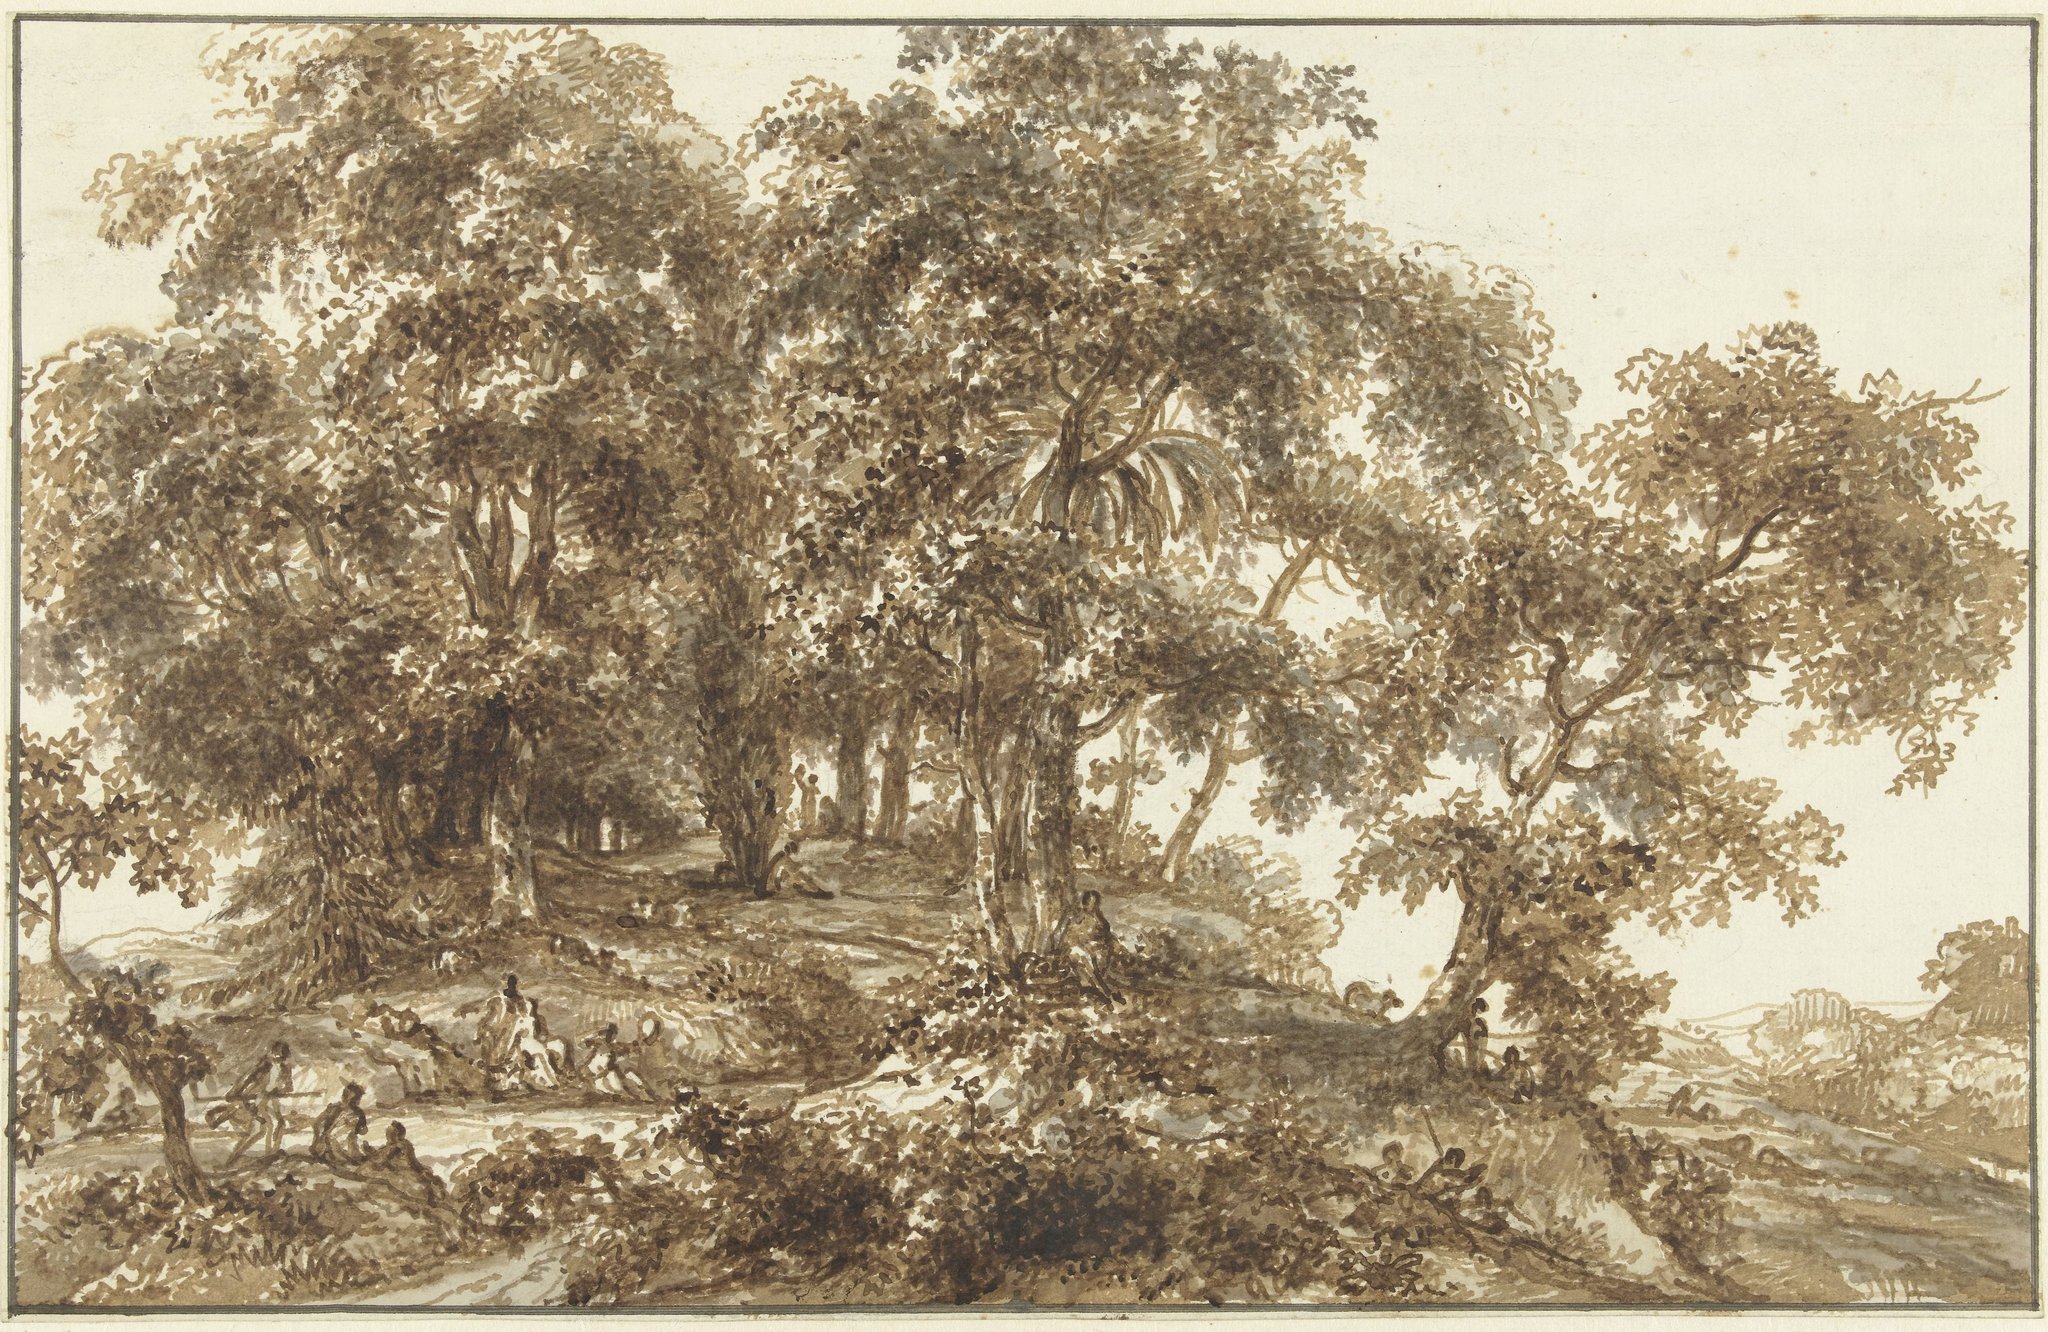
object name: drawing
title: Landschap met bomengroep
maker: jurriaan andriessen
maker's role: draughtsman, painter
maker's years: 1742-1819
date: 1752-1819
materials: ink, paper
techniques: brush, pen